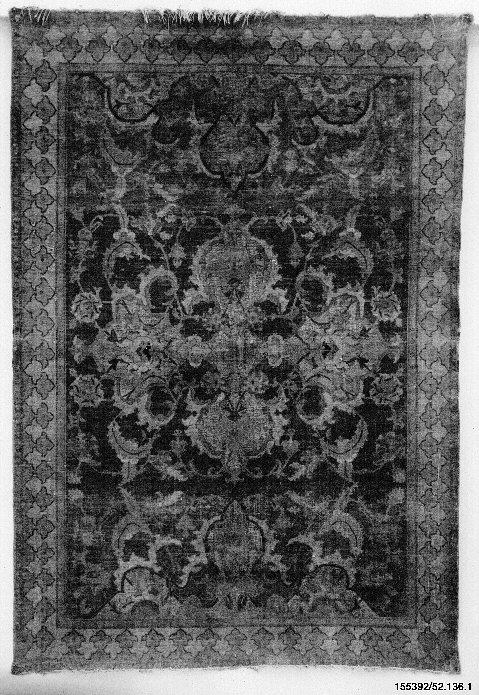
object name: carpet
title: Polonaise Carpet with Trefoil Border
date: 1601-1700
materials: metal thread, silk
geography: iran